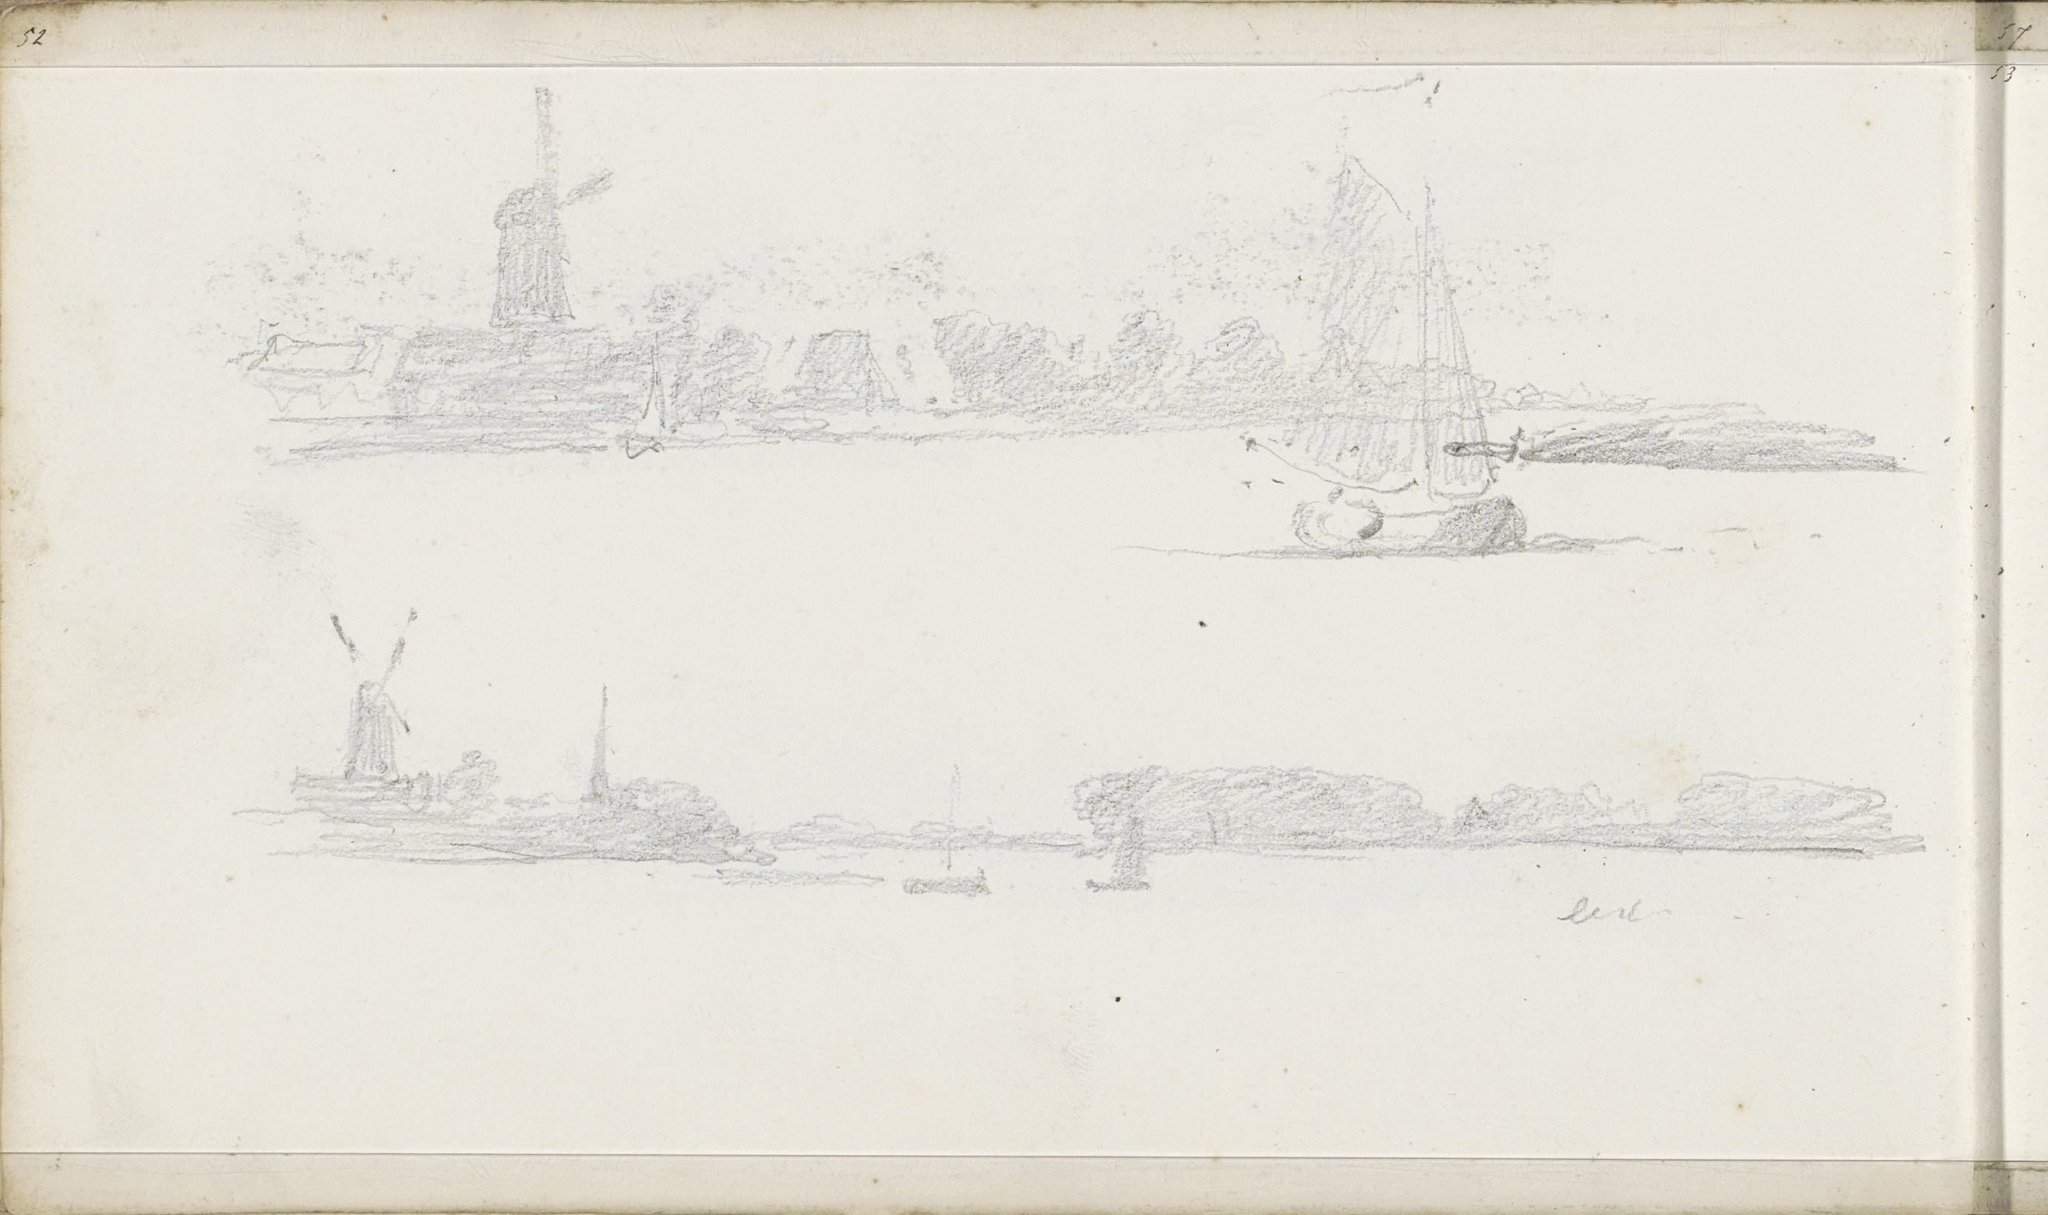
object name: sketchbook leaf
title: Riviergezichten met molens langs de Lek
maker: petrus johannes schotel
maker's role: draughtsman, painter, print maker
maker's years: 1808-1865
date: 1841-1865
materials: paper, pencil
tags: river, windmill in landscape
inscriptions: annotation: ‘lek’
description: Pagina 52 uit een schetsboek met 80 pagina's.